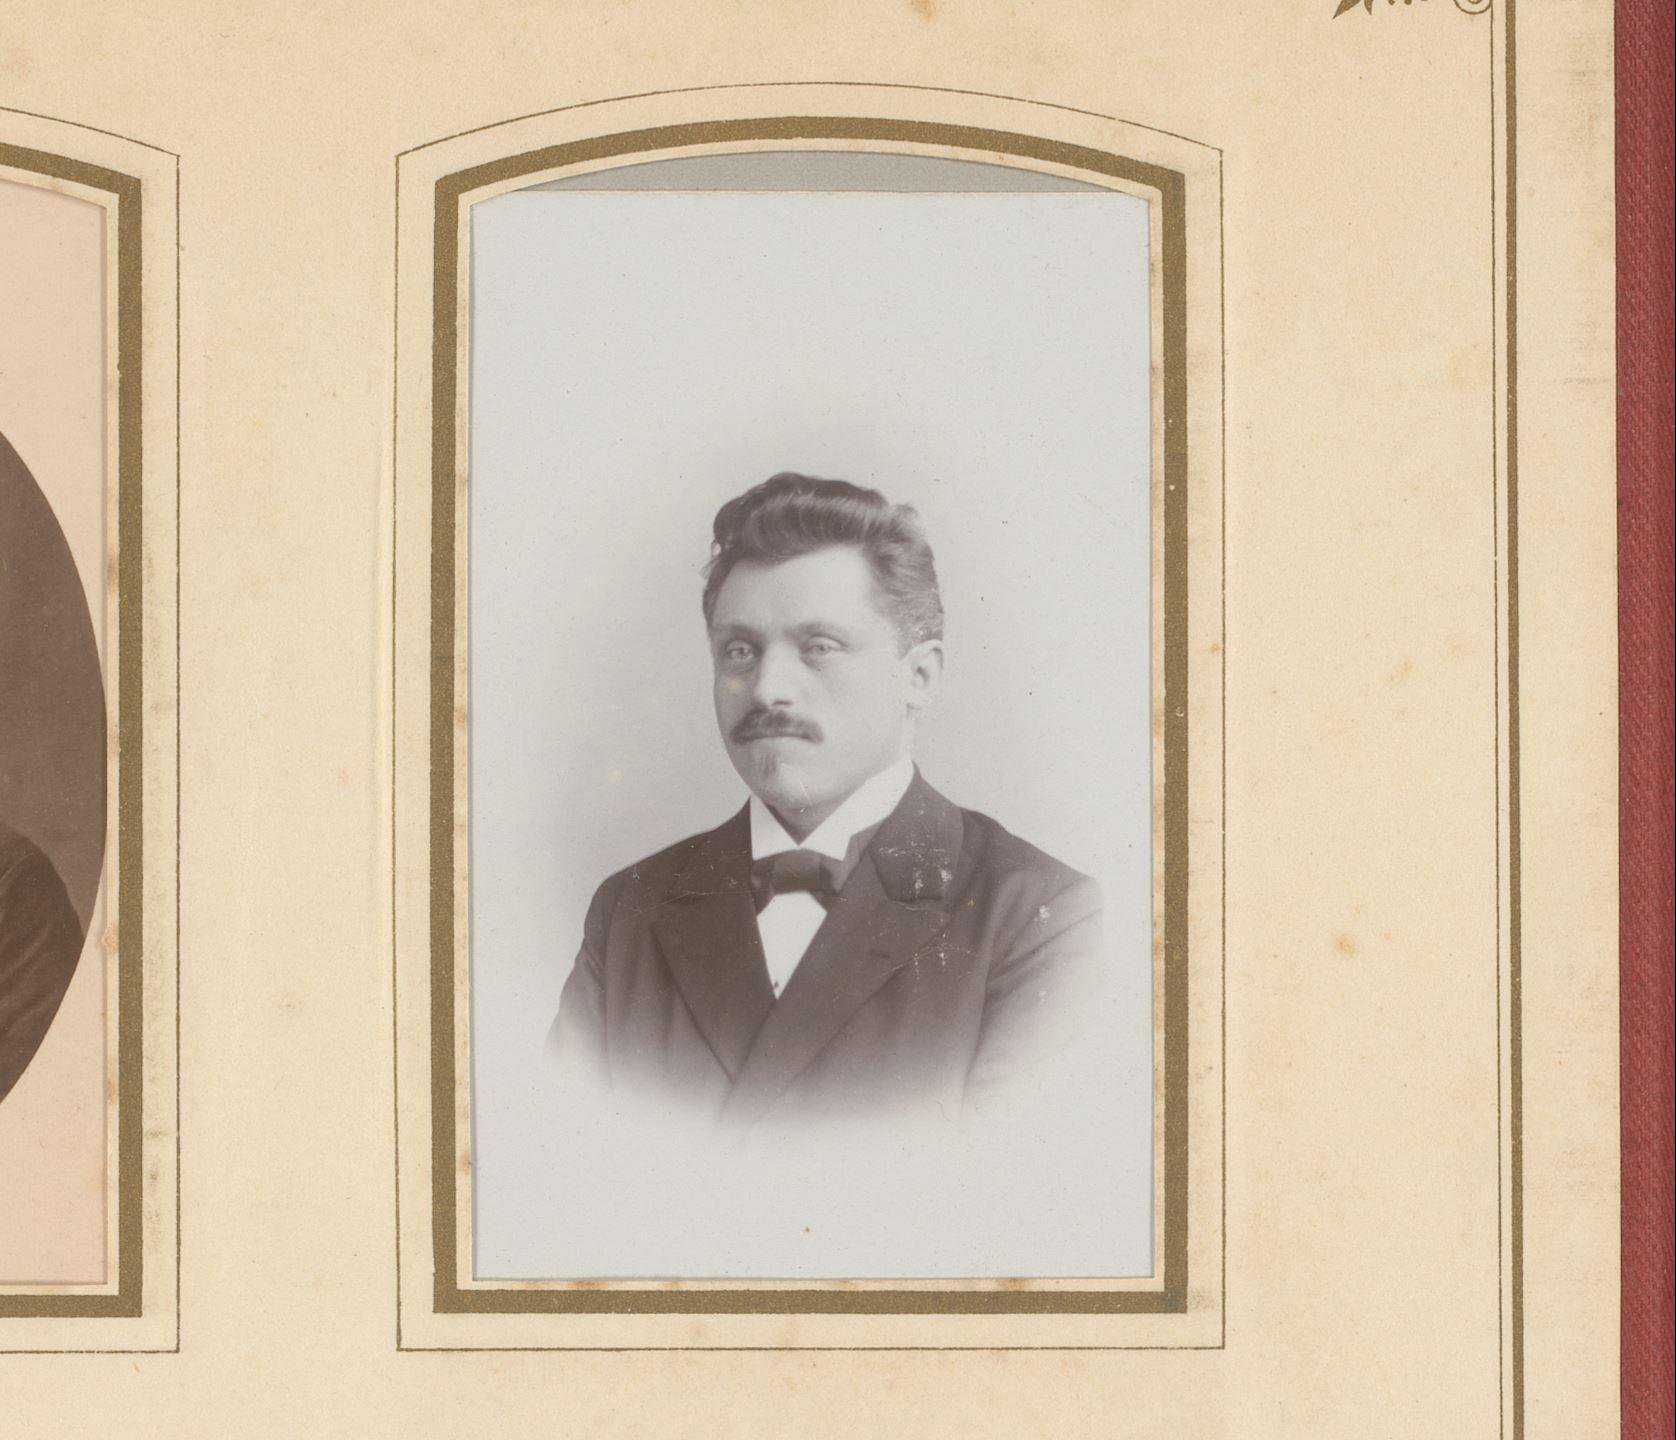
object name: album leaf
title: Portret van een man met snor en vlinderstrik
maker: Anonymous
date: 1880-1920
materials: cardboard, photographic support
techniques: collodion silver print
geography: netherlands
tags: moustache, historical persons